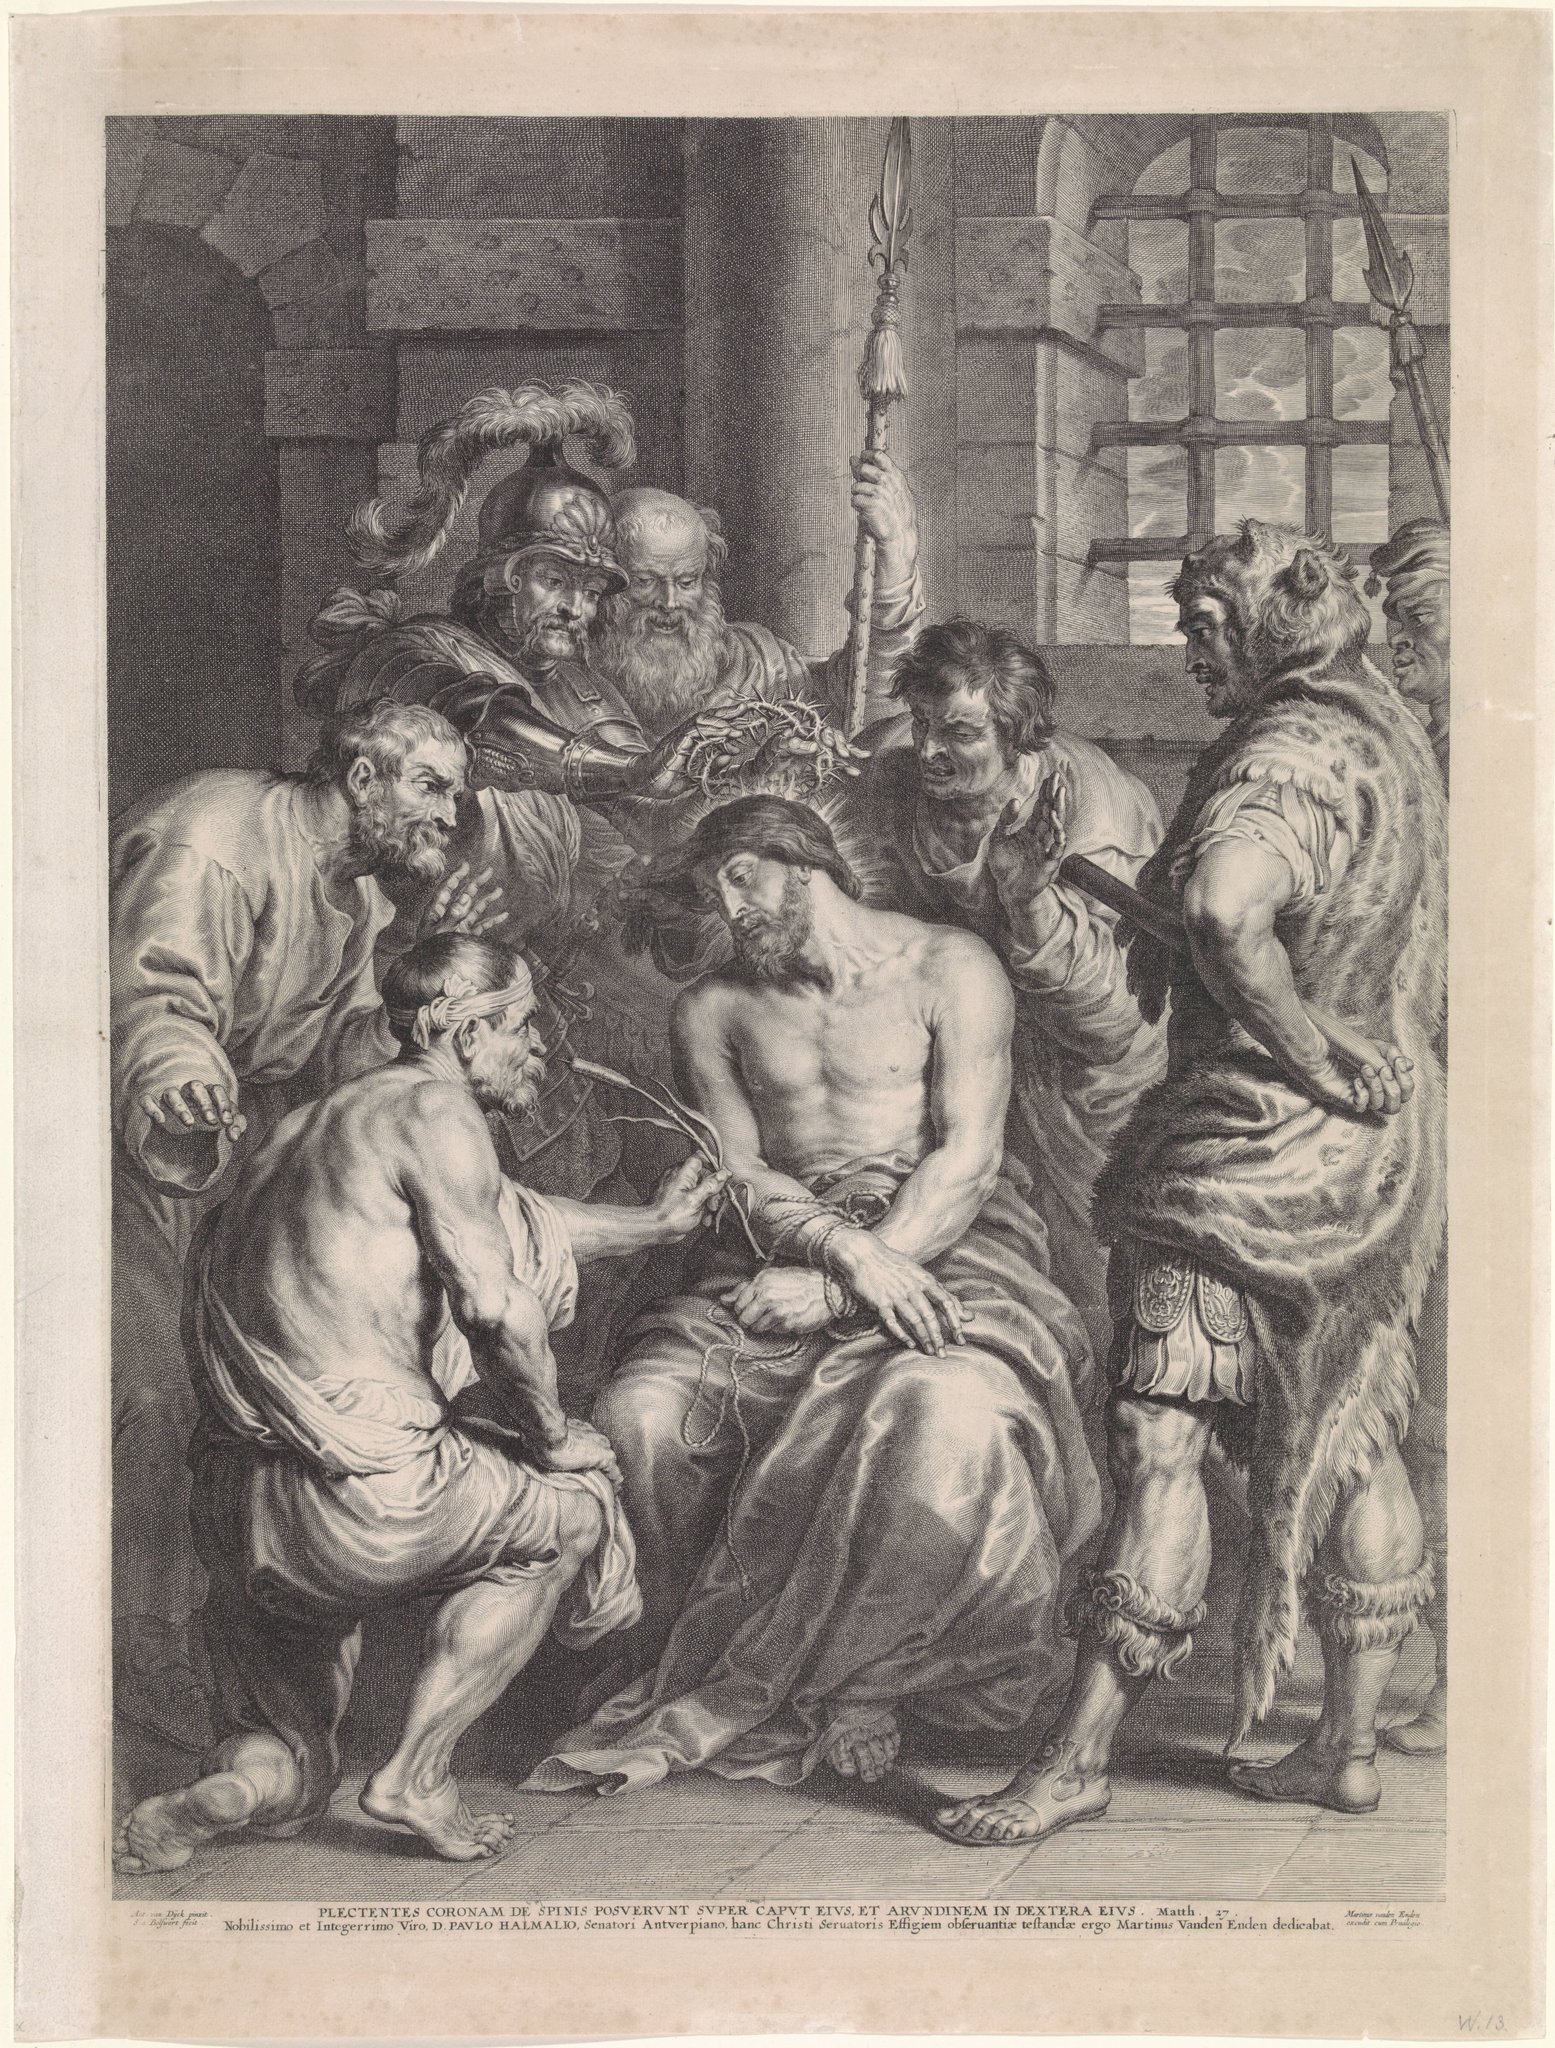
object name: print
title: Doornenkroning van Christus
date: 1596-1659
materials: paper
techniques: engraving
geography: antwerp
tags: the crowning with thorns: soldiers with sticks place a thorny crown on christ's head and give him a reed (matthew 27:27-31; mark 15:16-20; john 19:2-3)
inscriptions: collector's mark: Lugt 2760, collector's mark: Lugt 2228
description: Doornenkroning van Christus. In de marge onder fragment van bijbeltekst Matteüs 27.